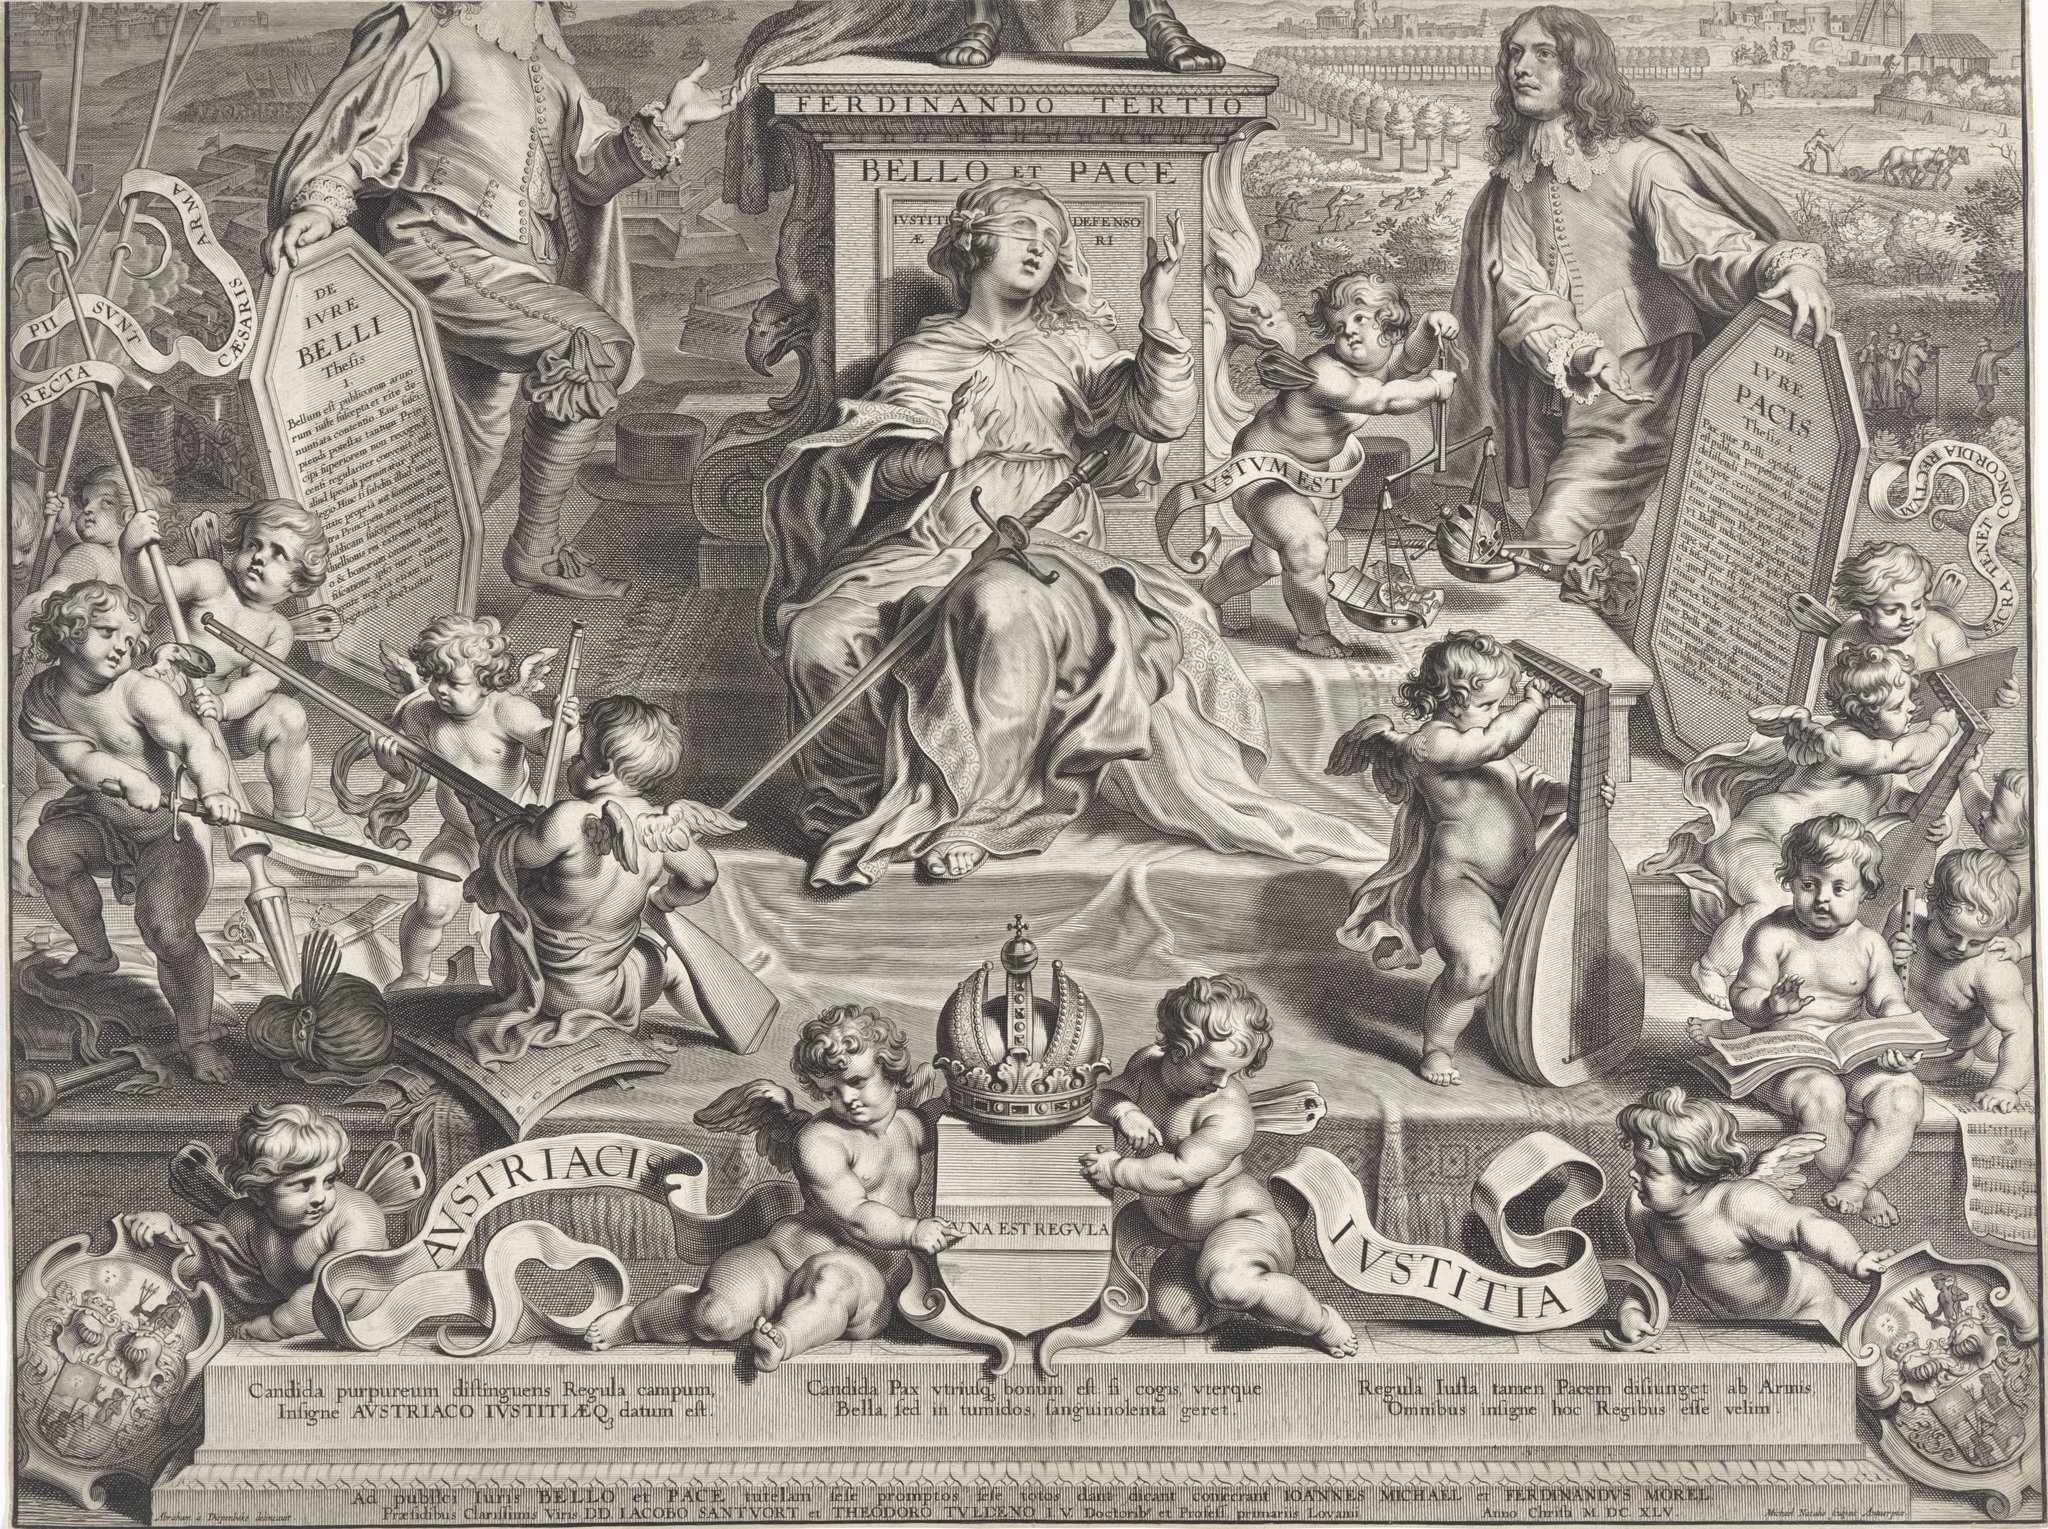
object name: print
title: Portret van keizer Ferdinand III met een allegorie op de oorlog en de vrede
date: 1645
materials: paper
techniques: engraving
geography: antwerp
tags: ferdinand iii (duits keizer), justice, 'justitia'; 'giustitia divina' (ripa) ~ one of the four cardinal virtues, war and peace, cupids: 'amores', 'amoretti', 'putti'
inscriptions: collector's mark: Lugt 240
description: Onderste gedeelte van een voorstelling met het portret van Duits keizer Ferdinand III met een allegorie op de oorlog en de vrede. Onder het standbeeld van ferdinand III zit de geblinddoekte Rechtvaardigheid (Justitia) met het zwaard, terwijl een putto haar weegschaal vasthoudt. Links presenteert een man met een stenen tafel de oorlog. Aan deze zijde van de voorstelling spelen putti met wapens en op de achtergrond in het landschap woedt oorlog en is brand. Rechts presenteert een man met een stenen tafel de vrede. Putti spelen met muziekinstrumenten, omdat in tijden van vrede de kunsten floreren. In het landschap wordt gejaagd en geploegd.